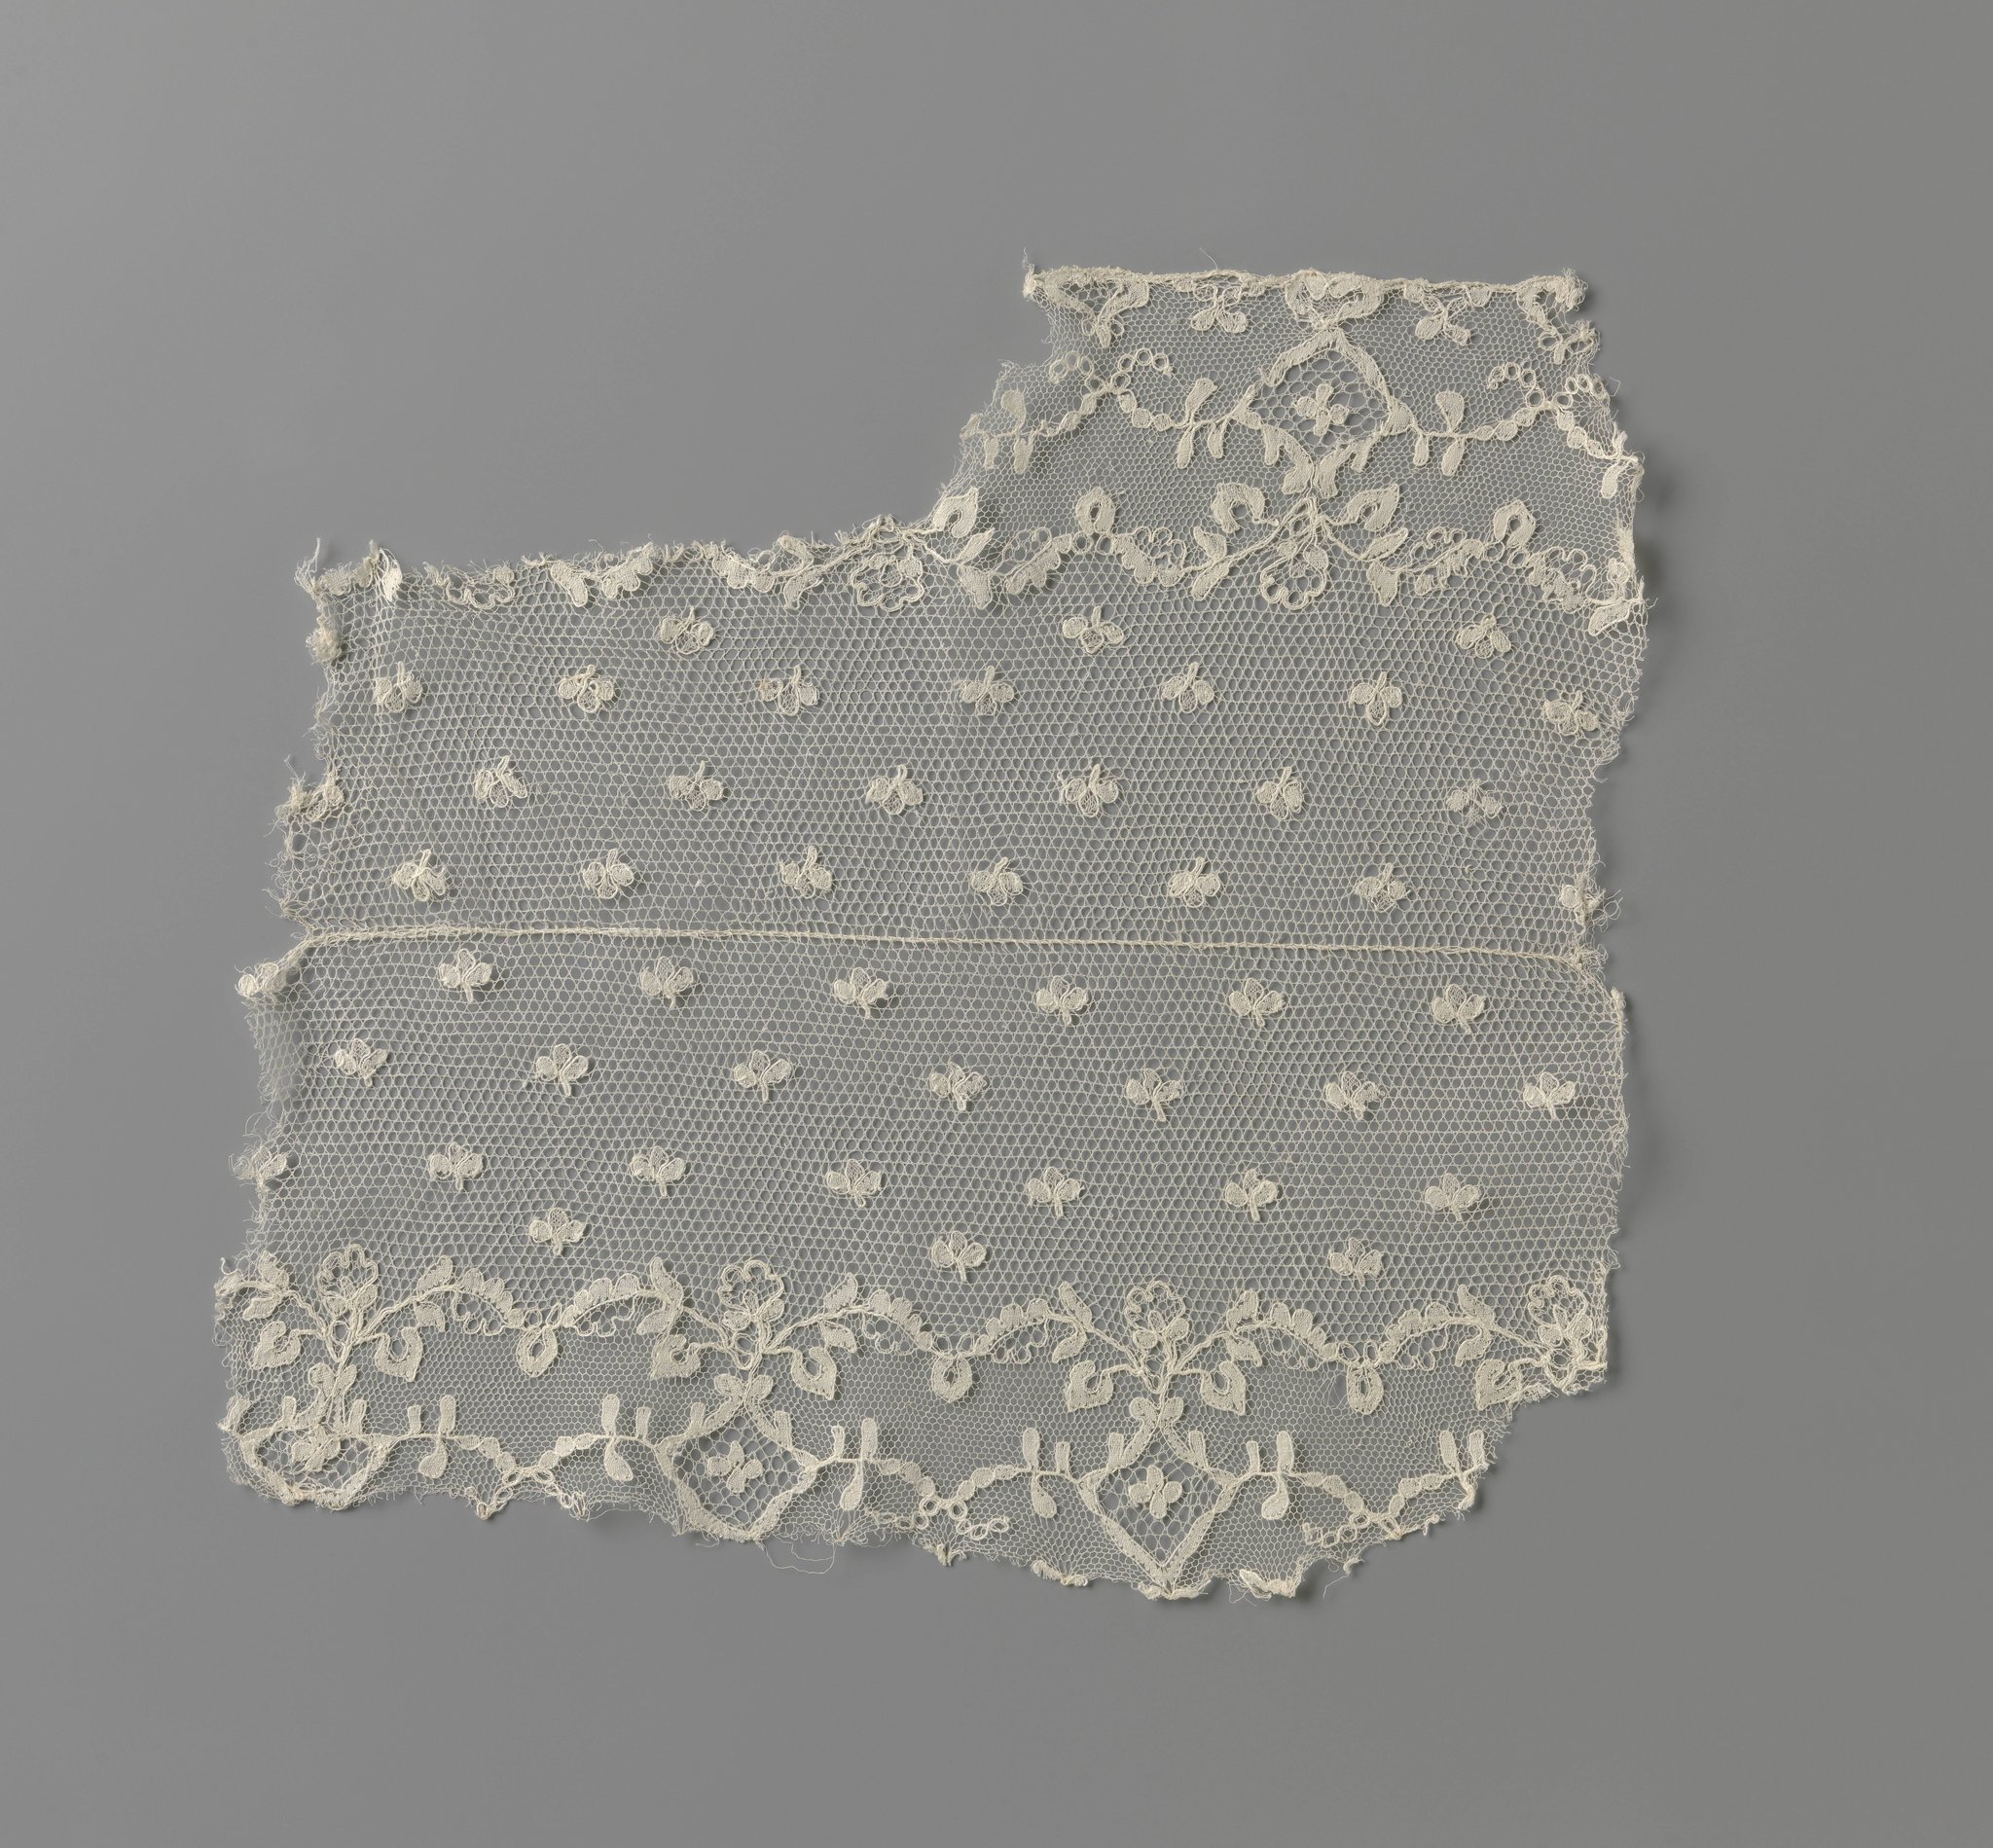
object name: dust ruffle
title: Volant van kloskant met ruitvormige medaillons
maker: Anonymous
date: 1870-1920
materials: linen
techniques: lace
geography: belgium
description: Volant van naturelkleurige kloskant: Parijse kant. De grond is in tweeën gedeeld in een Parijse grond met klaverblaadjes bovenaan en een tulegrond daaronder. In de laatste staat een symmetrisch patroon van ruitvormige opengewerkte medaillons met zijranken bekroond door een bloem tussen twee bladeren. De bladeren, de zijranken en een reeks bloempjes en rankjes in de schulprand staan in drie gesloten slingers los boven elkaar. De motieven zijn gemaakt in linnenslag en voorzien van contourdraden. Als siergrond is een rozengrond toegepast. BK-BR-J-375-G en -I zijn in de lengte aan elkaar genaaid. Van beide stroken is een gedeelte afgeknipt van de onderrand, alleen bij -I is nog een klein gedeelte van de onderrand ongeschonden.